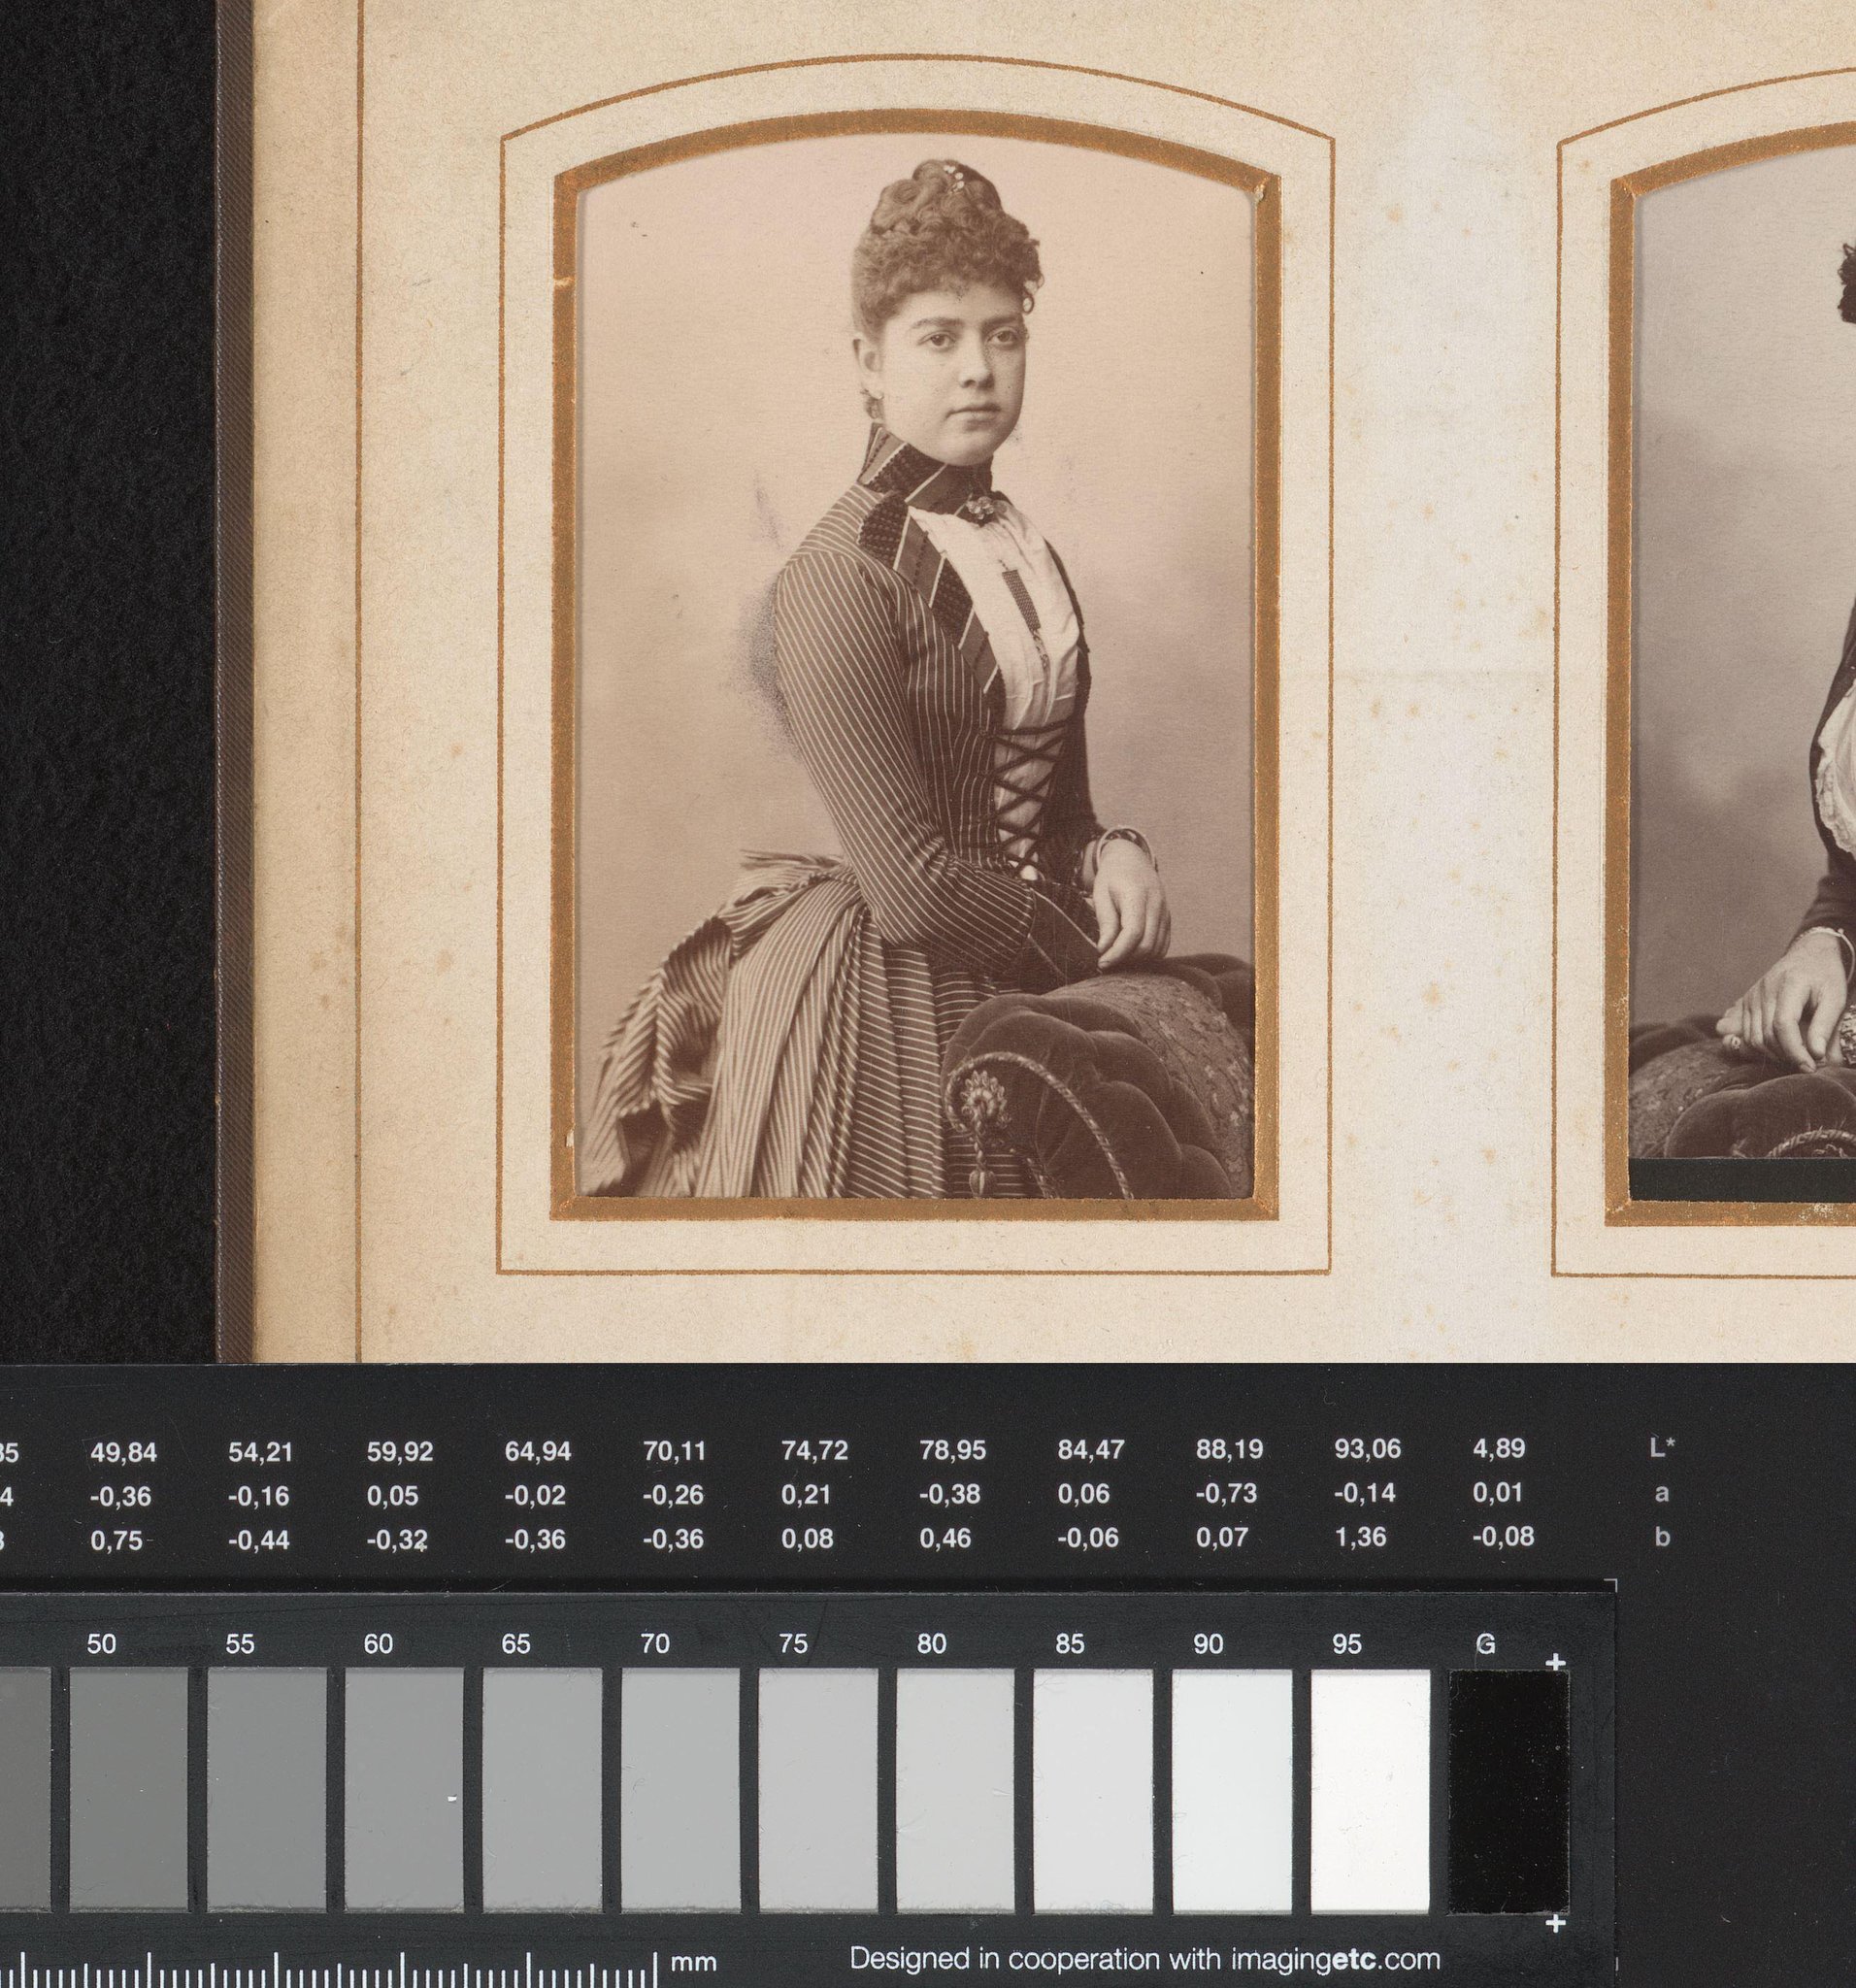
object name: photograph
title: Portret van een staande jonge vrouw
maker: oscar json runstedt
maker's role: fotograaf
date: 1860-1900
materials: cardboard, photographic support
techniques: albumen print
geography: stockholm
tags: adolescent, young woman, maiden, historical persons - bb - woman, standing figure - aa - female human figure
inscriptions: inscription: ‘Oscar Json Runstedt/ Stockholm/ 15 Brunkebergstorg/ Plåten förvaras för efterbeställning.’